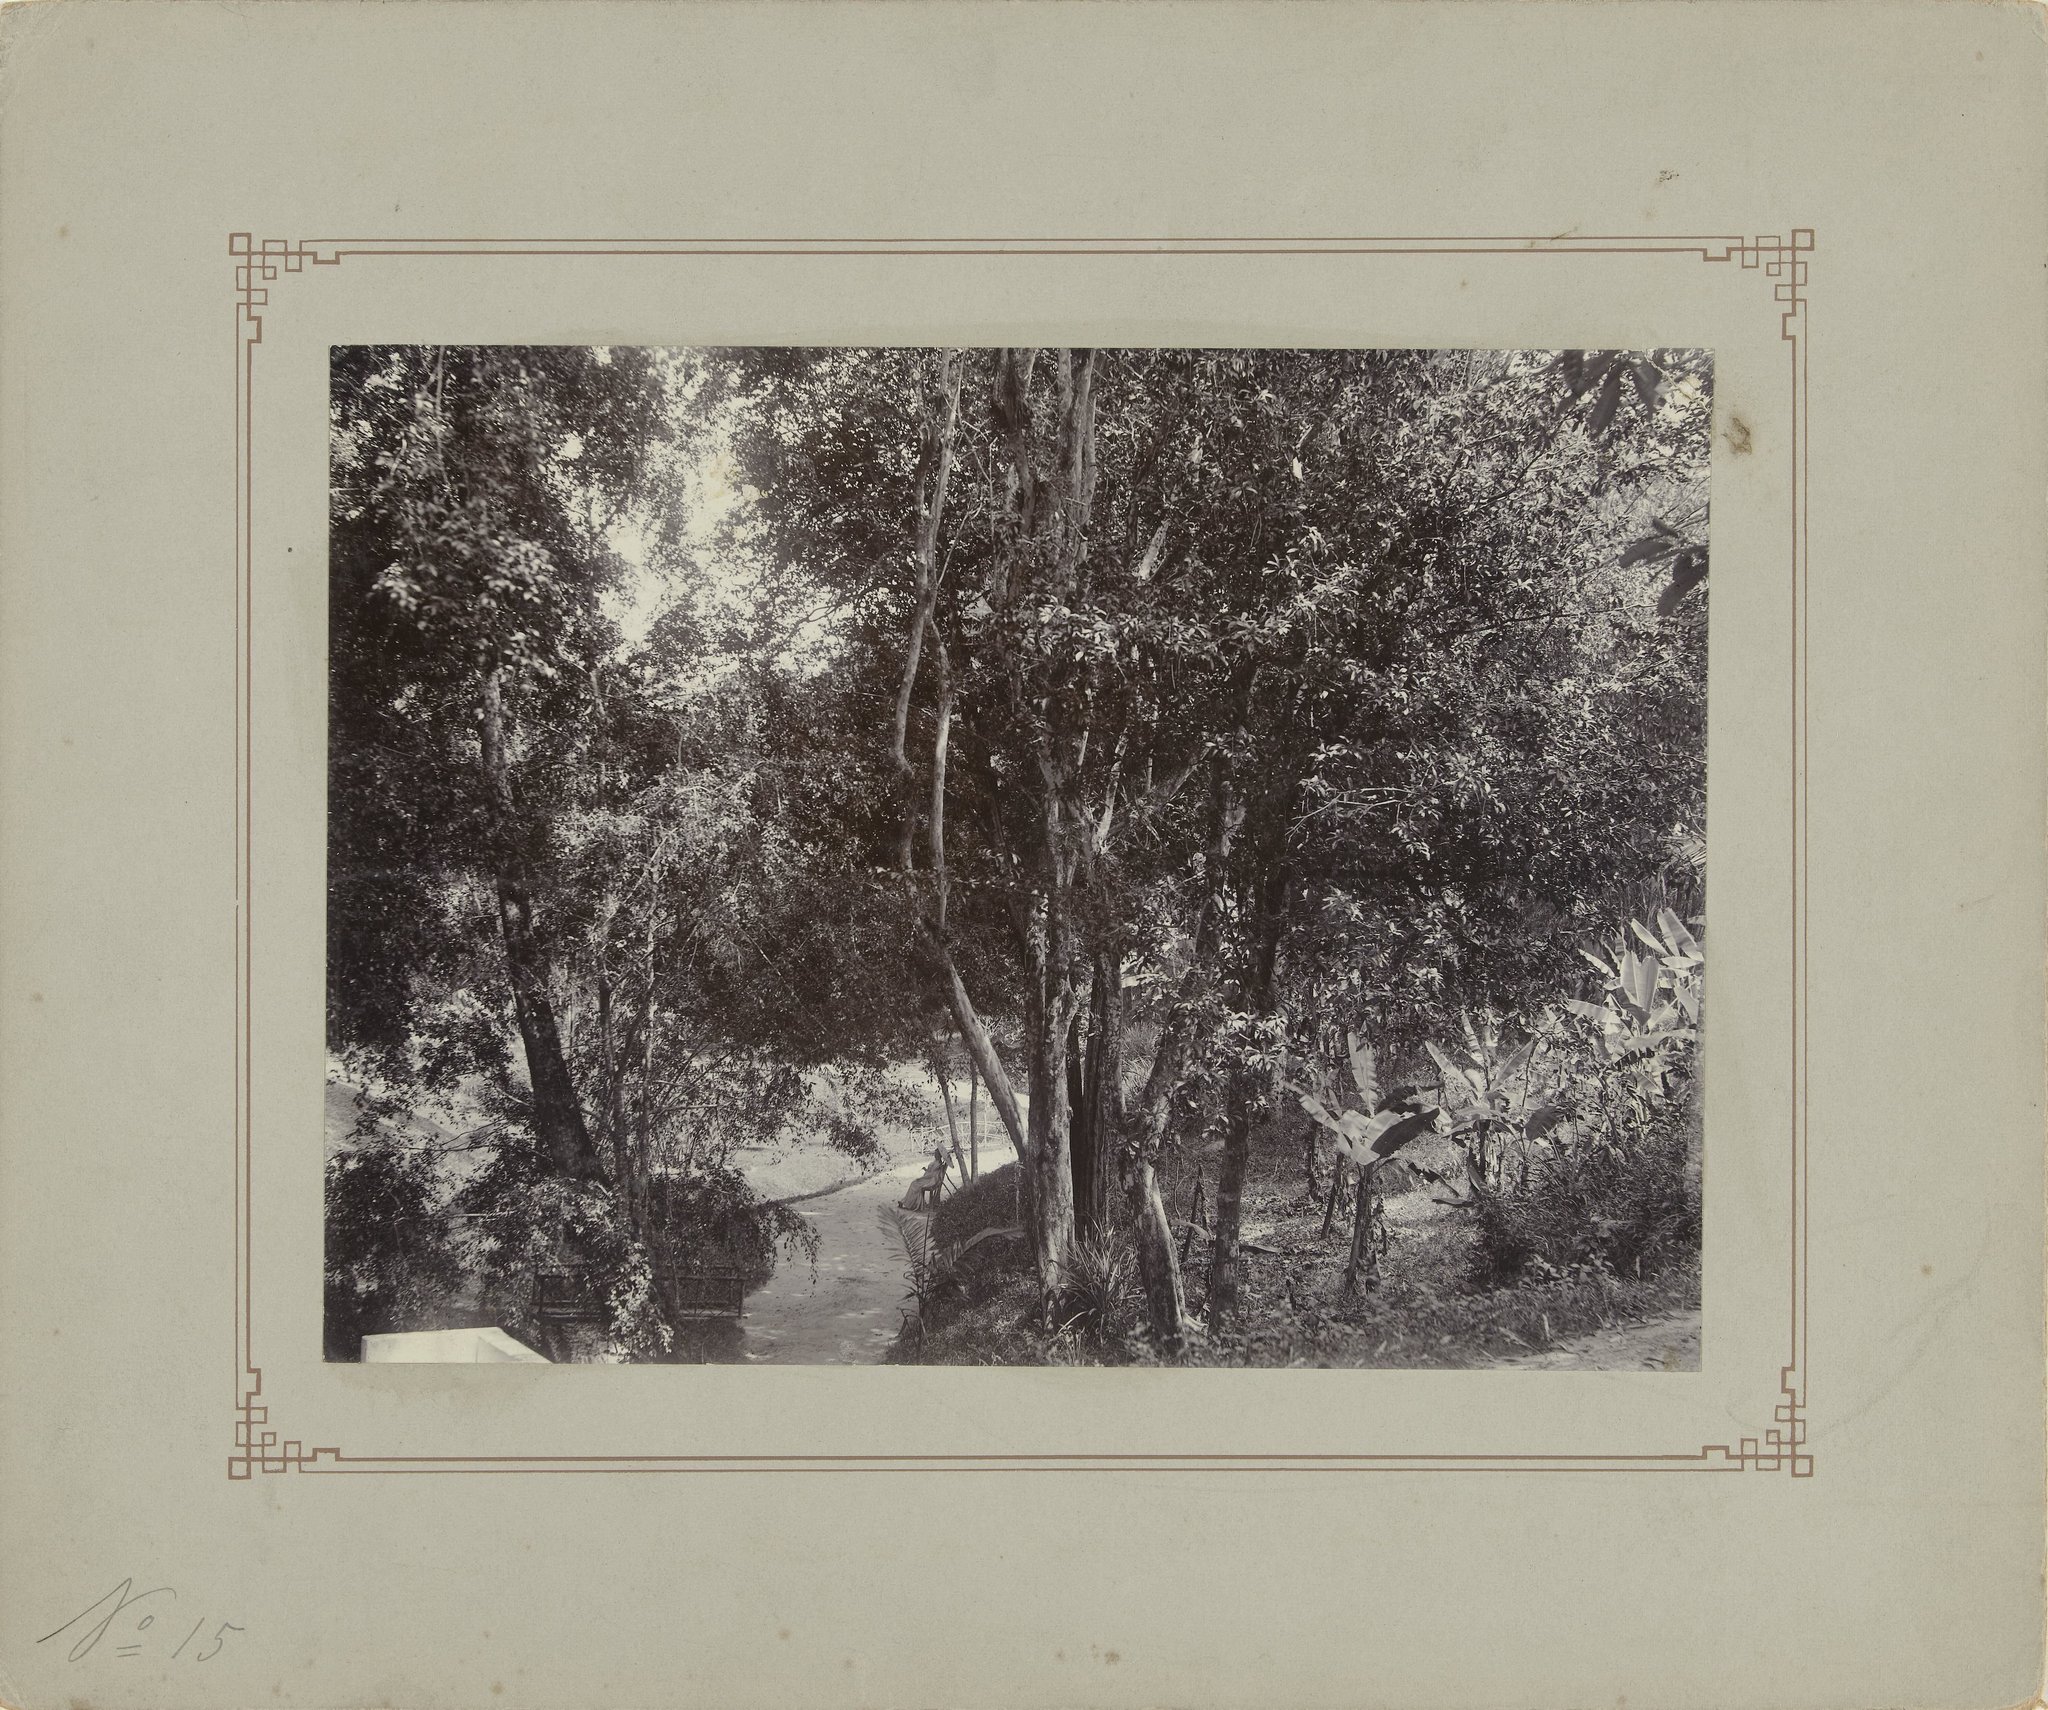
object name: photograph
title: Vrouw met parasol in bos of park in Nederlands-Indië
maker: Anonymous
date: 1890-1920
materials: paper, cardboard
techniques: gelatin silver print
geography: dutch east indies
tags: park, trees, forest, wood, parasol, sunshade, dutch east indies, the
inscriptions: number: ‘No 15’